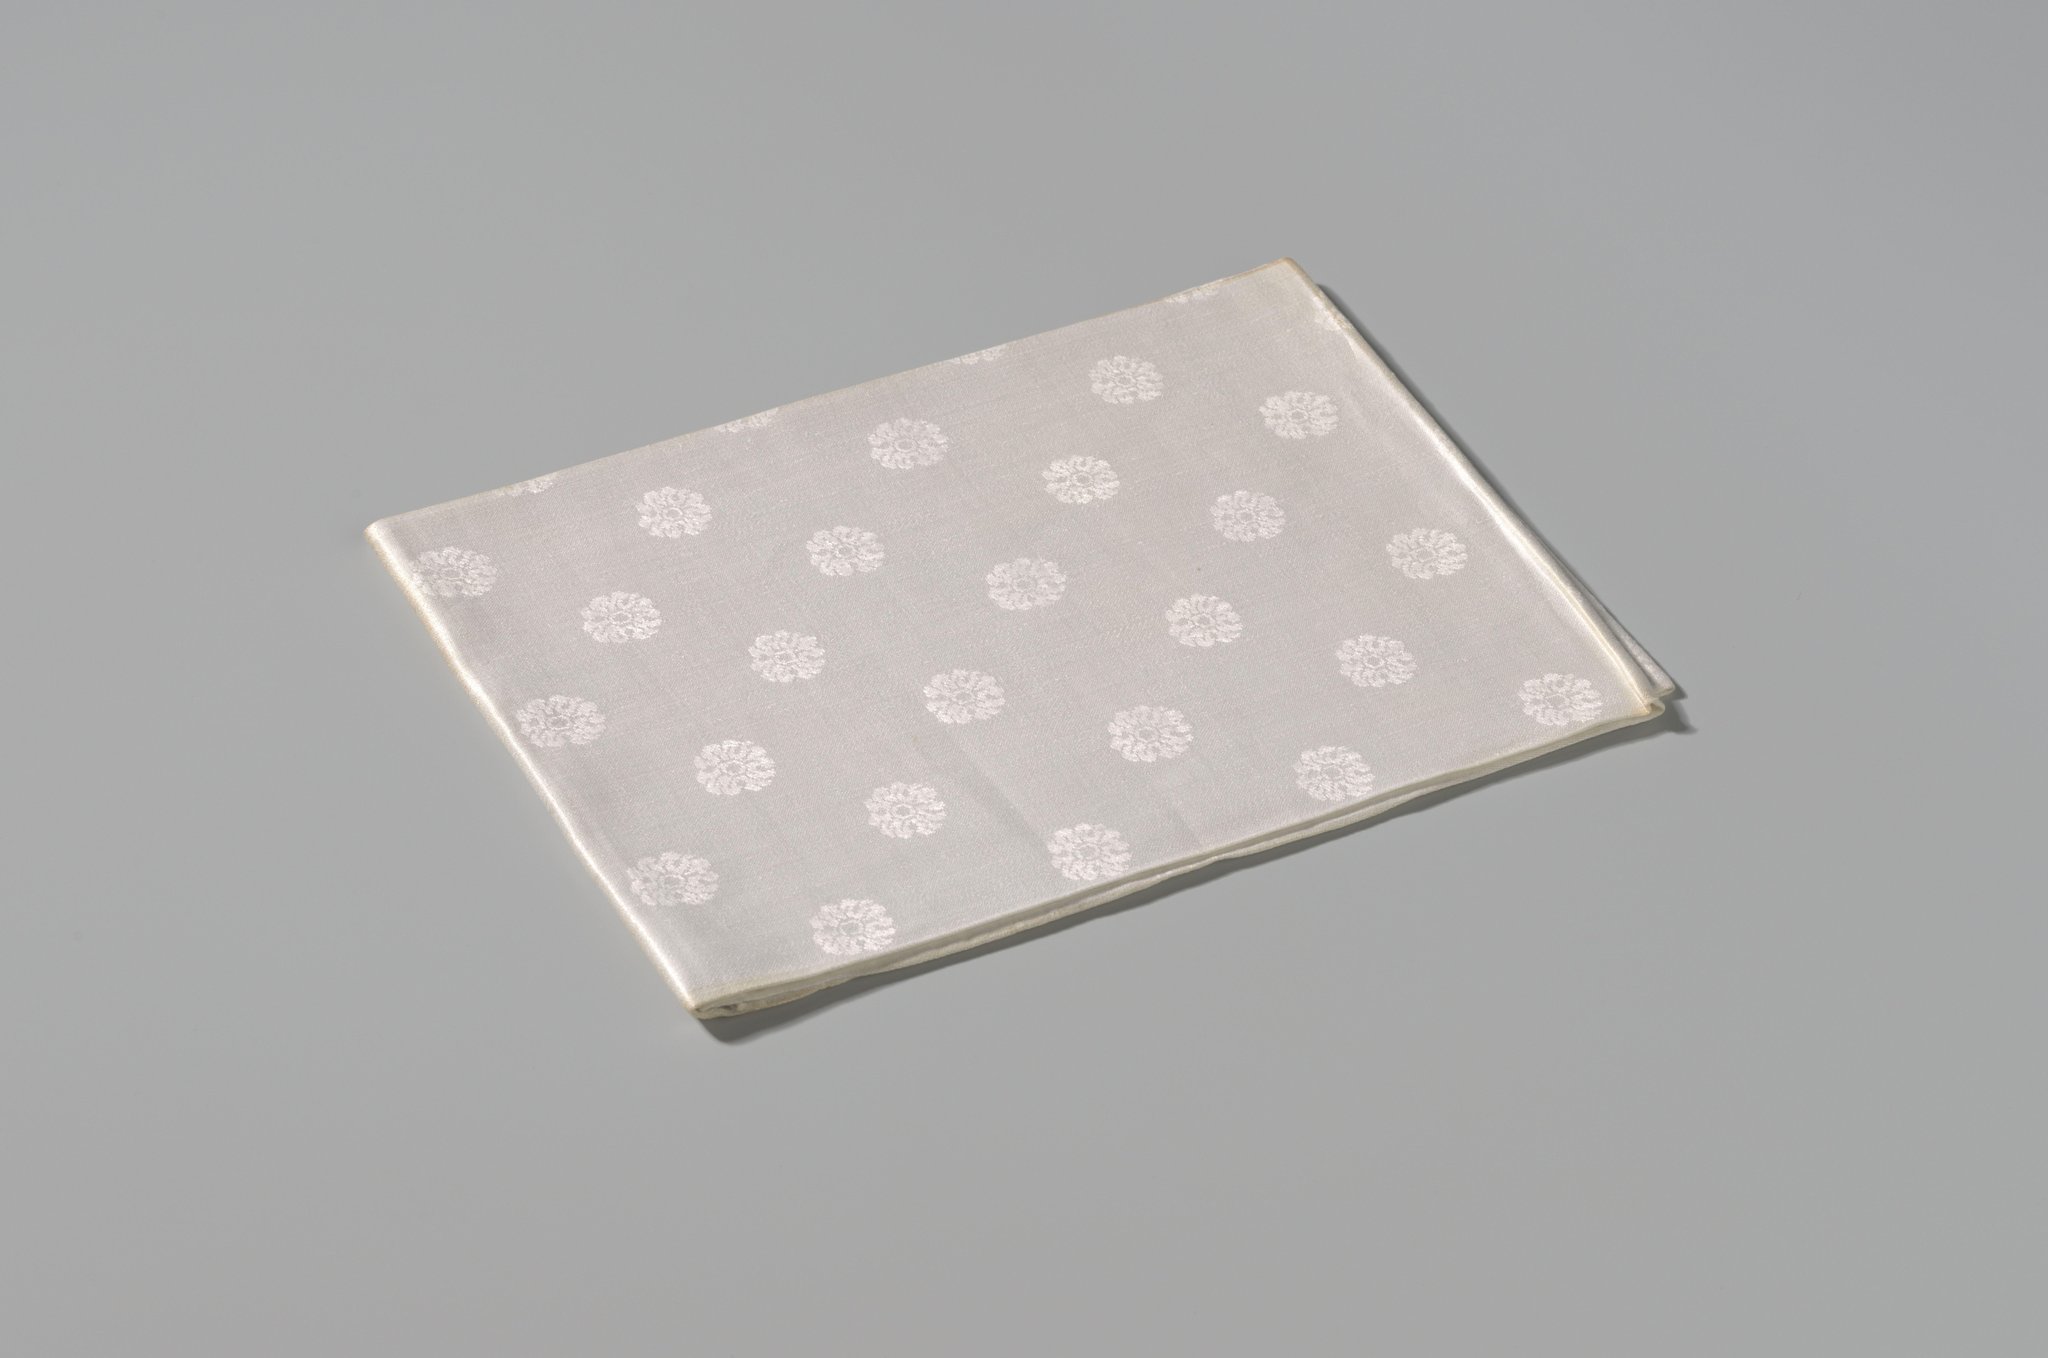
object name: napkin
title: Servet met patroon van rozetten en rozentakken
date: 1780-1800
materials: linen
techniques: damask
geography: northern netherlands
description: Wit linnendamasten servet met een patroon van rozetten en rozentakken, merk 2 en HW 30.